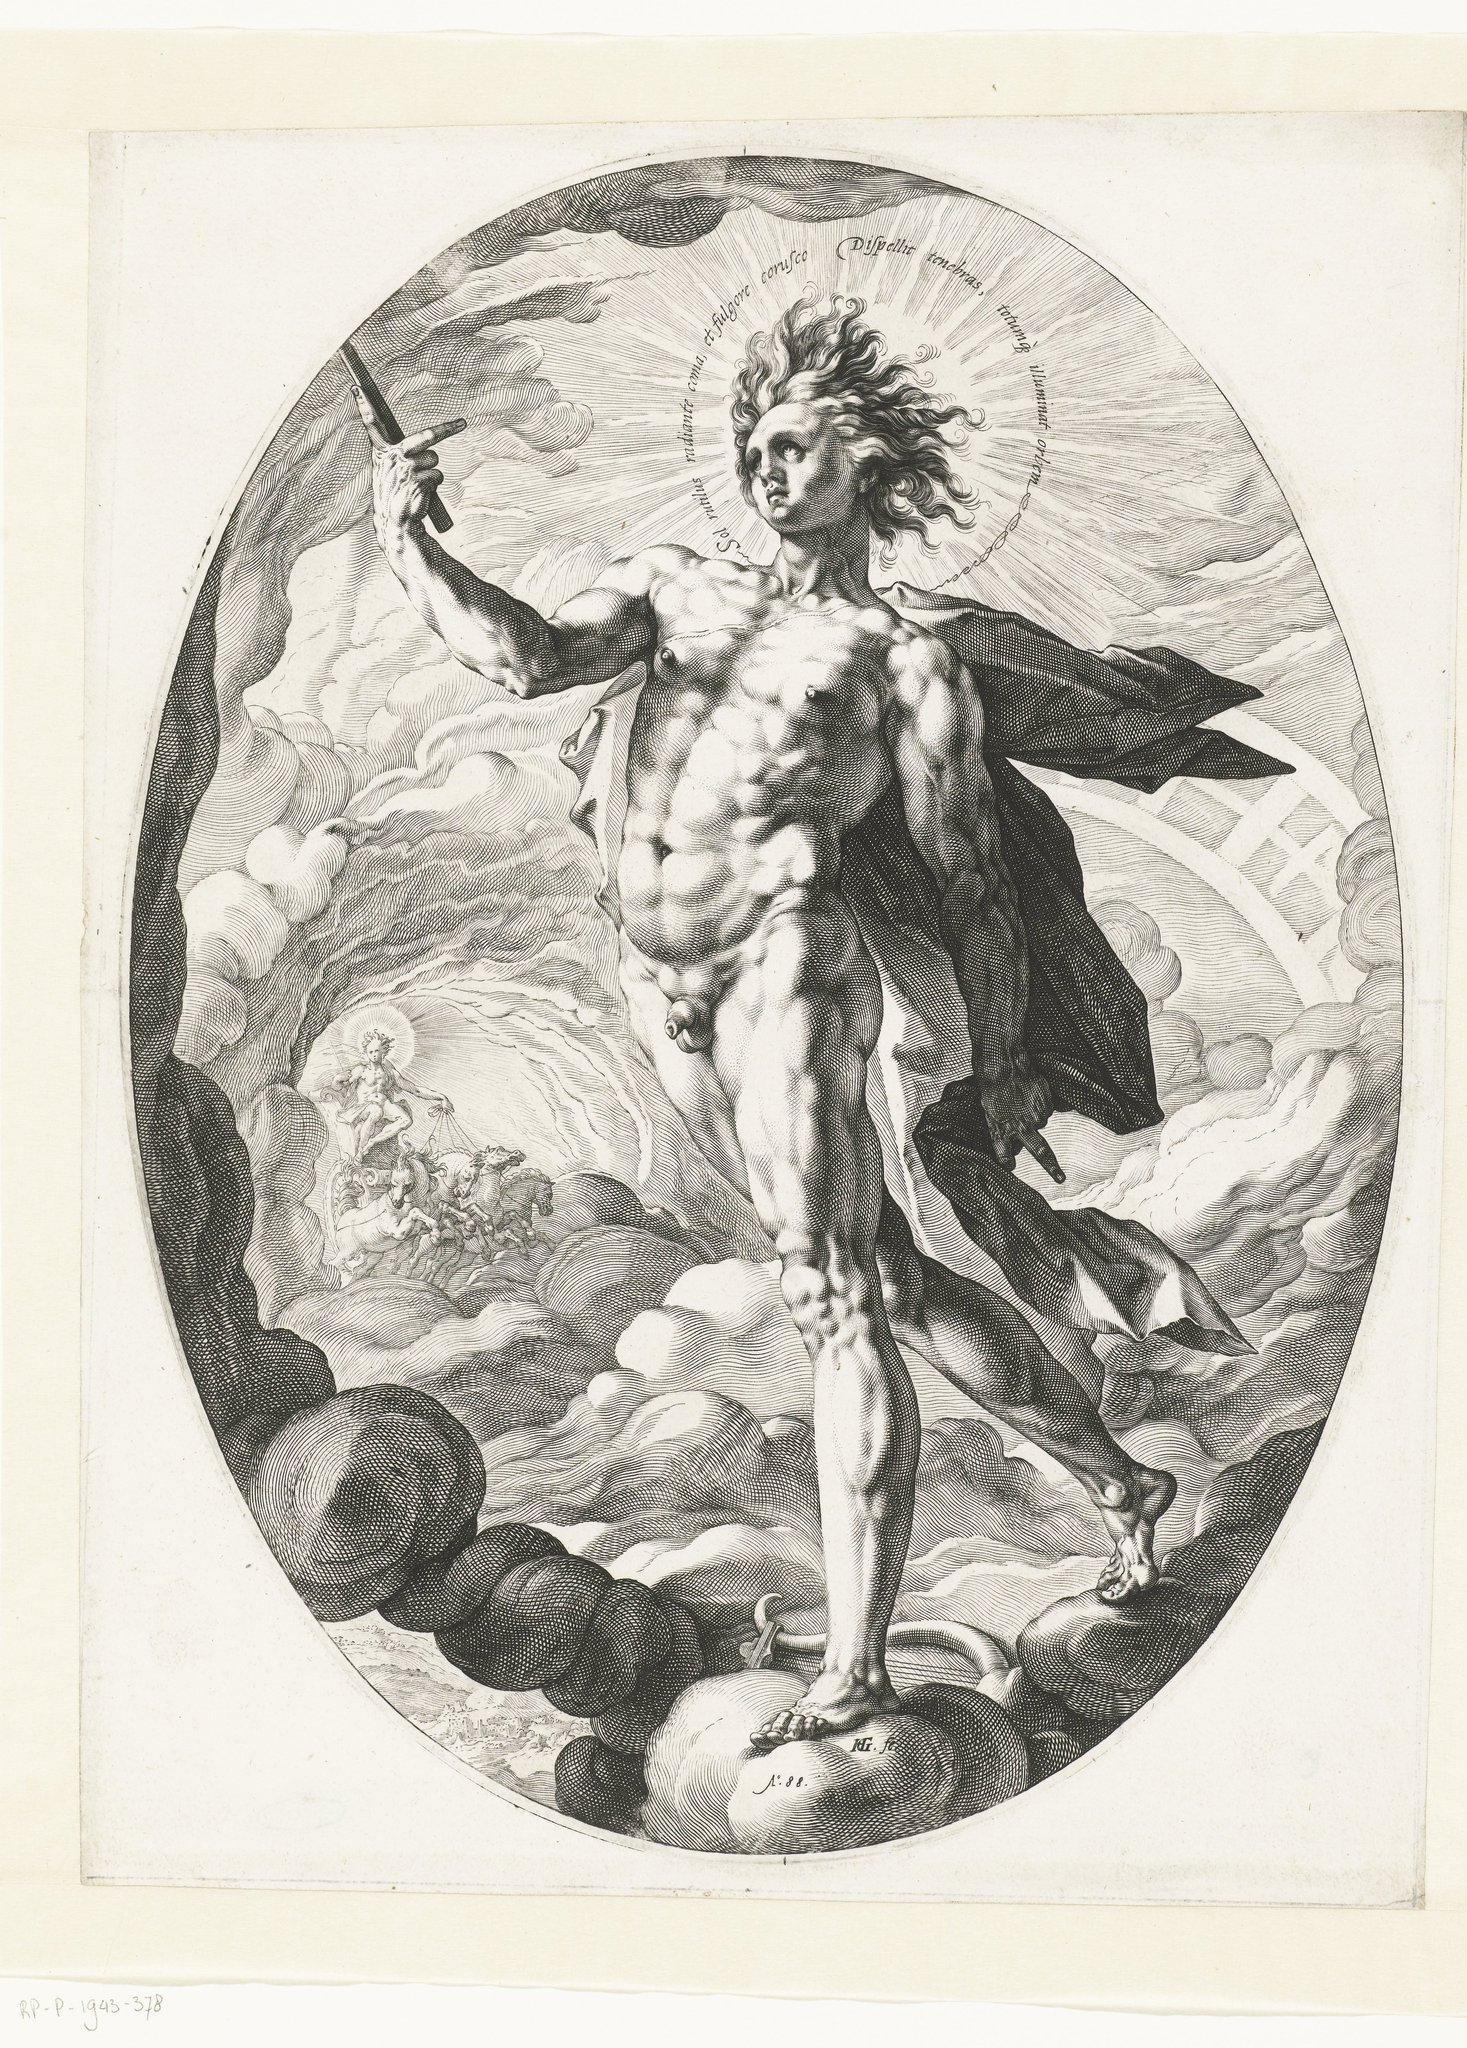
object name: print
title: Apollo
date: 1588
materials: paper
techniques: engraving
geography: haarlem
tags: (story of) apollo (phoebus)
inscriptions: signature: ‘HG. fe’, collector's mark: Lugt 2760, date: ‘Ao. 88’, collector's mark: Lugt 2228a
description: Ovale voorstelling van de god Apollo die met vlammende haardos door een kolkende wolkenmassa schrijdt, om zijn hoofd een Latijns opschrift in de vorm van een aureool. Op de achtergrond is te zien hoe hij op zijn zonnewagen rijdt.